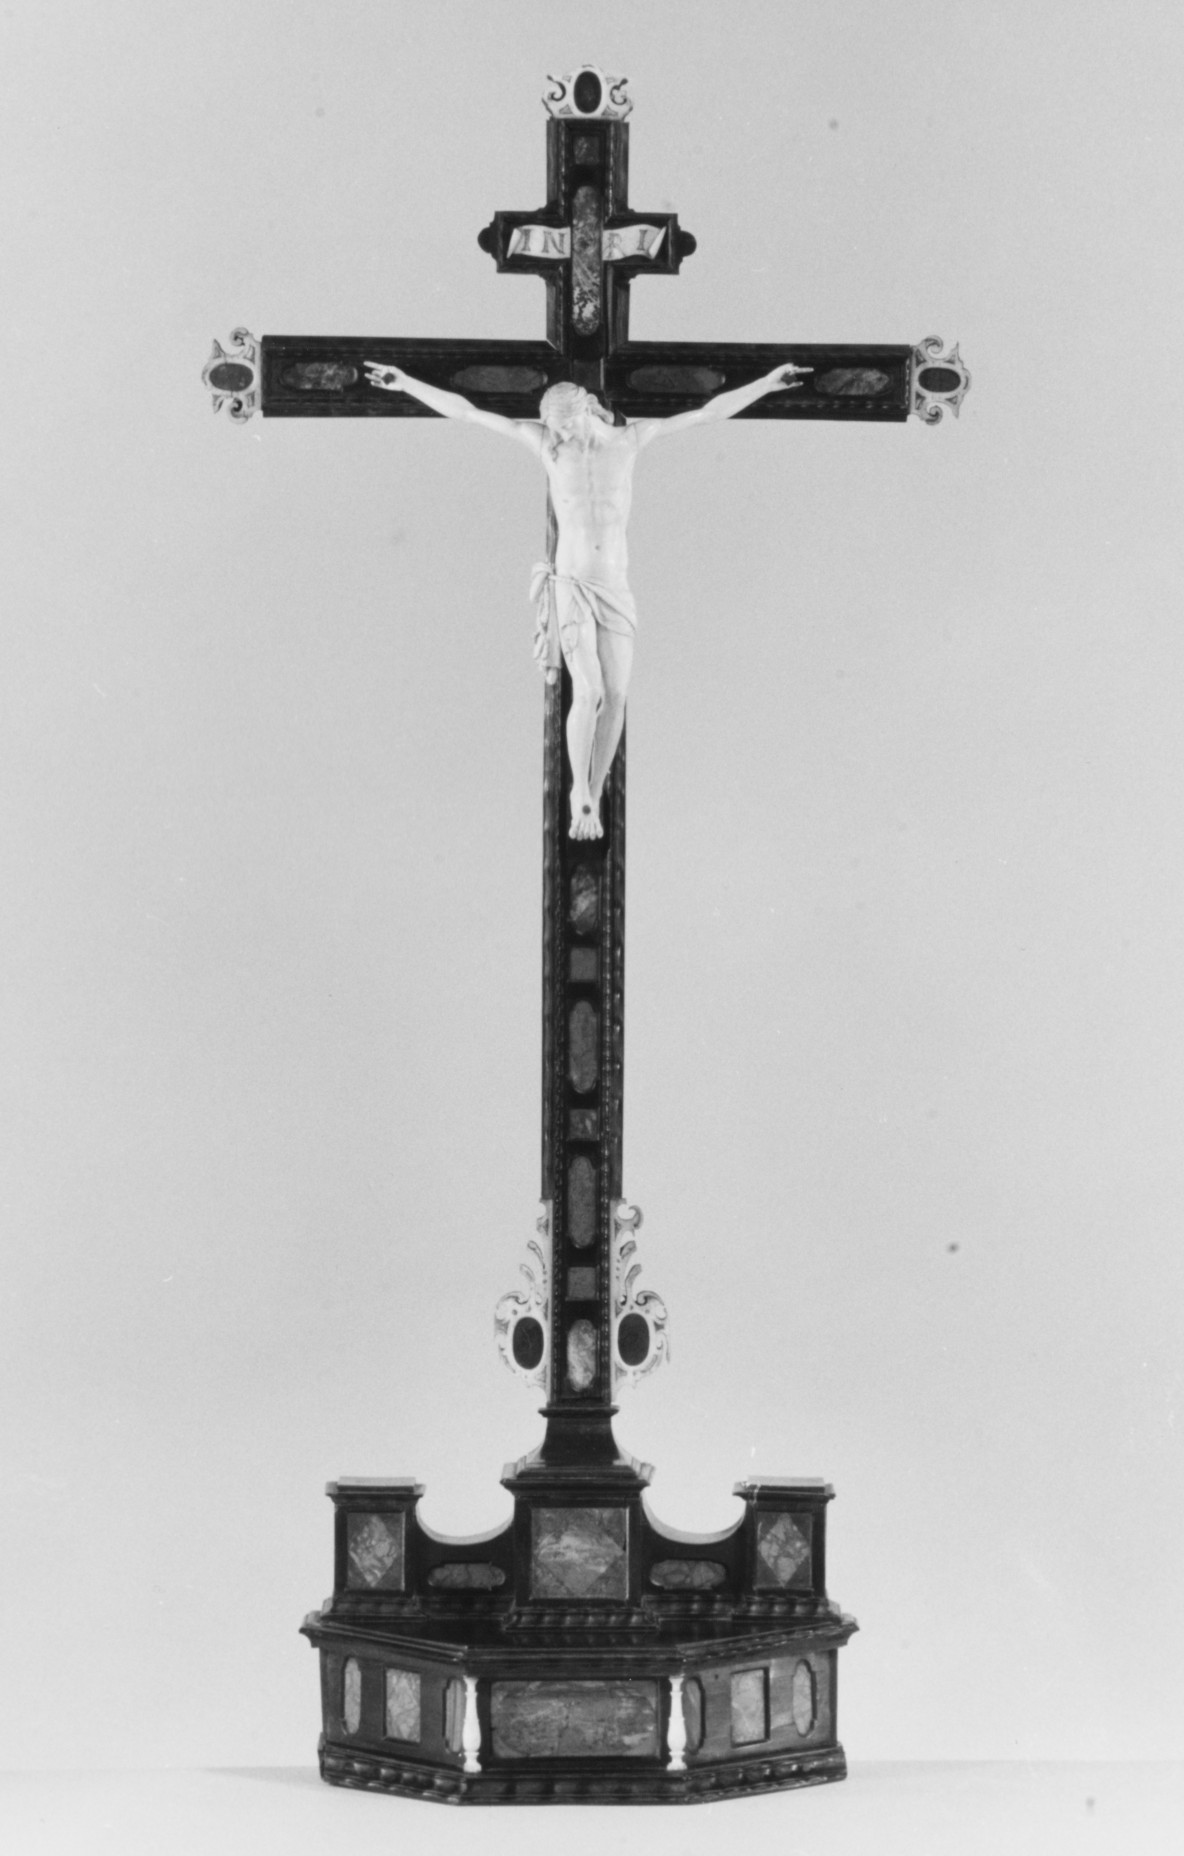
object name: crucifix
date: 1601-1633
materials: stone, wood, ivory, lapis lazuli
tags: jesus,crucifixion